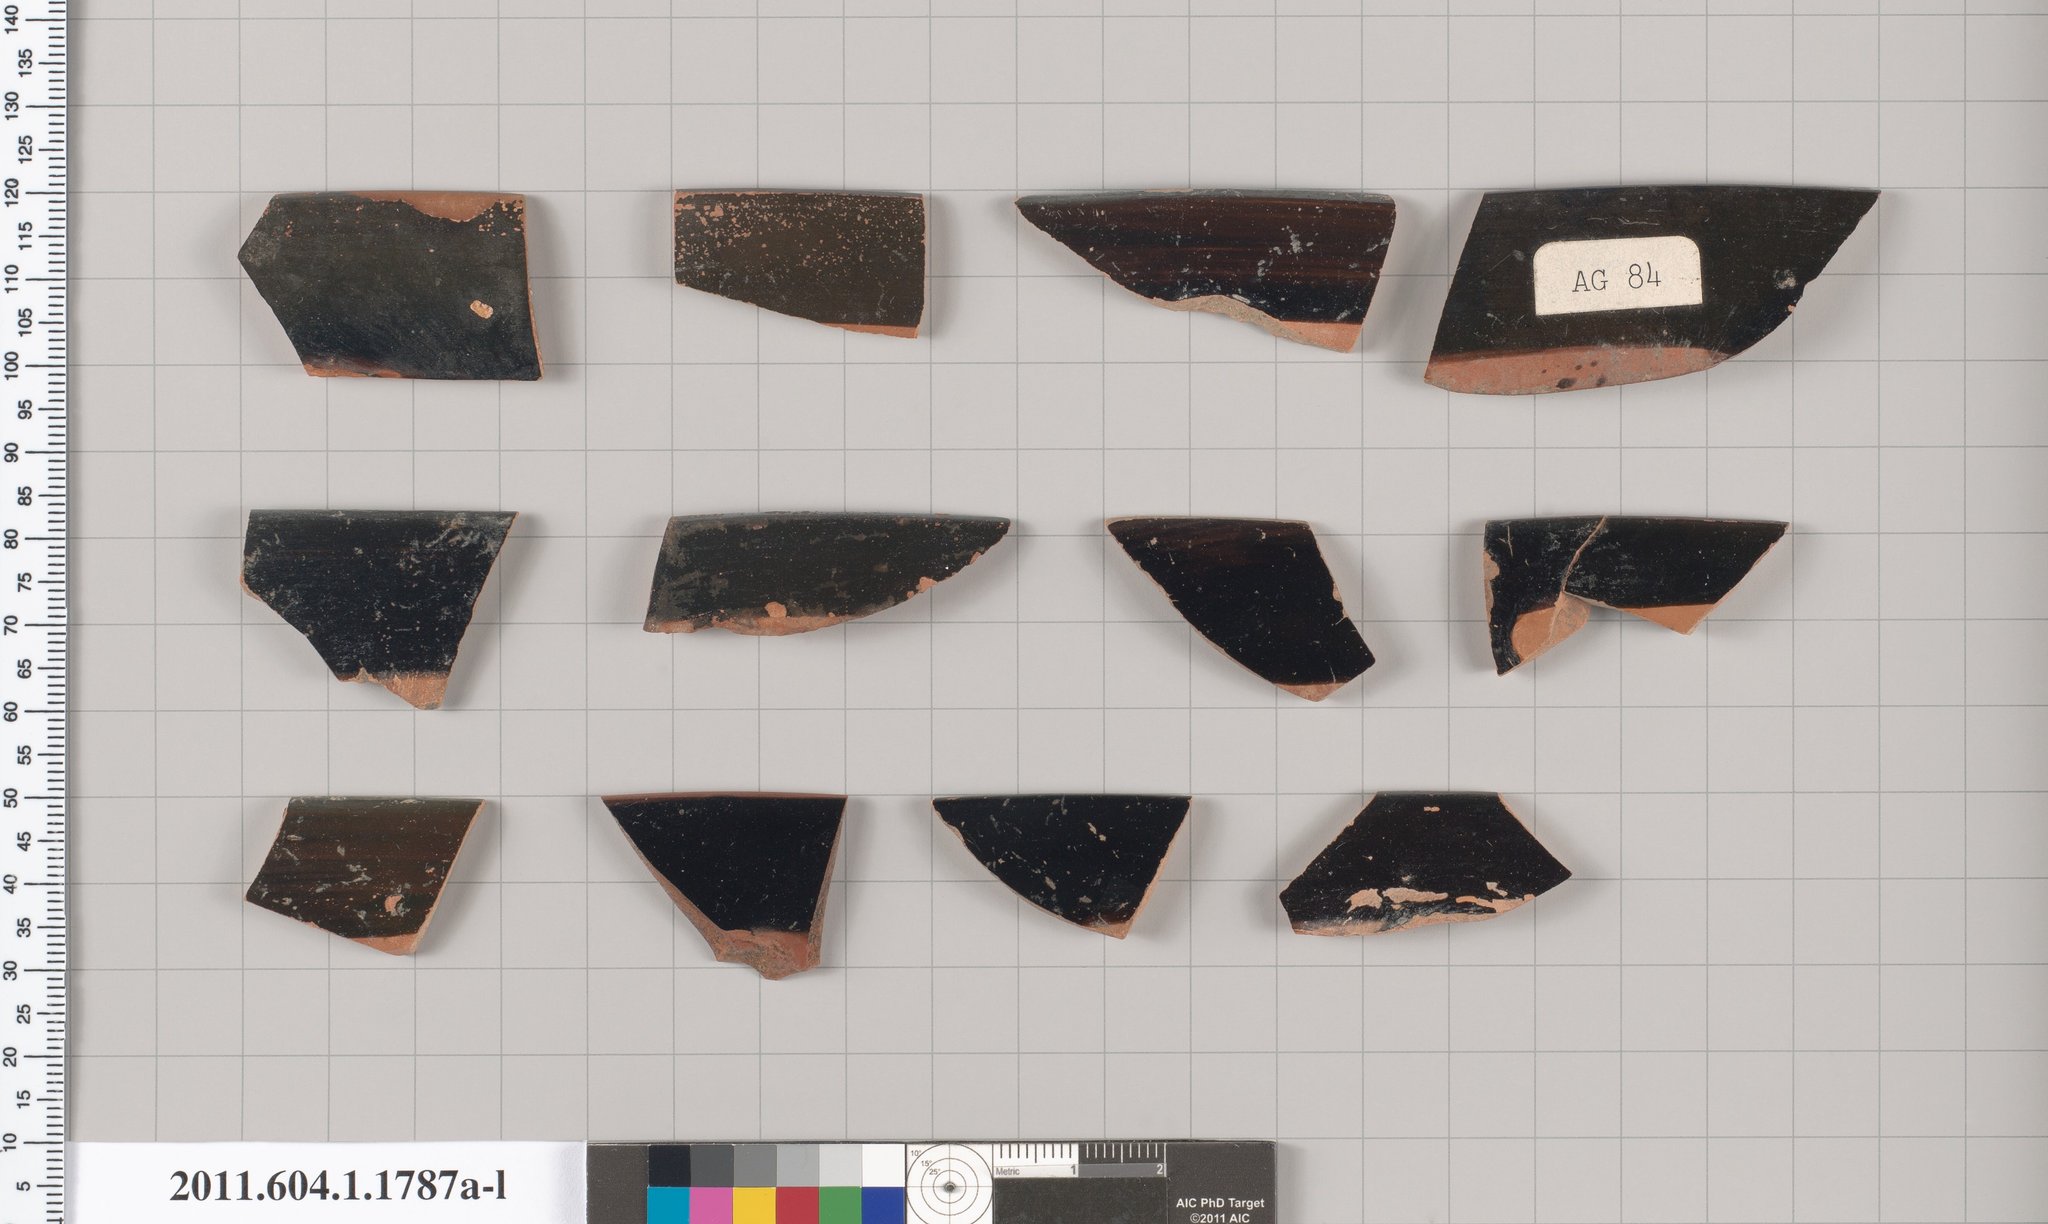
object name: kylix fragment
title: Terracotta rim fragments of kylikes(drinking cups)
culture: greek, attic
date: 500-401 BCE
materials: terracotta